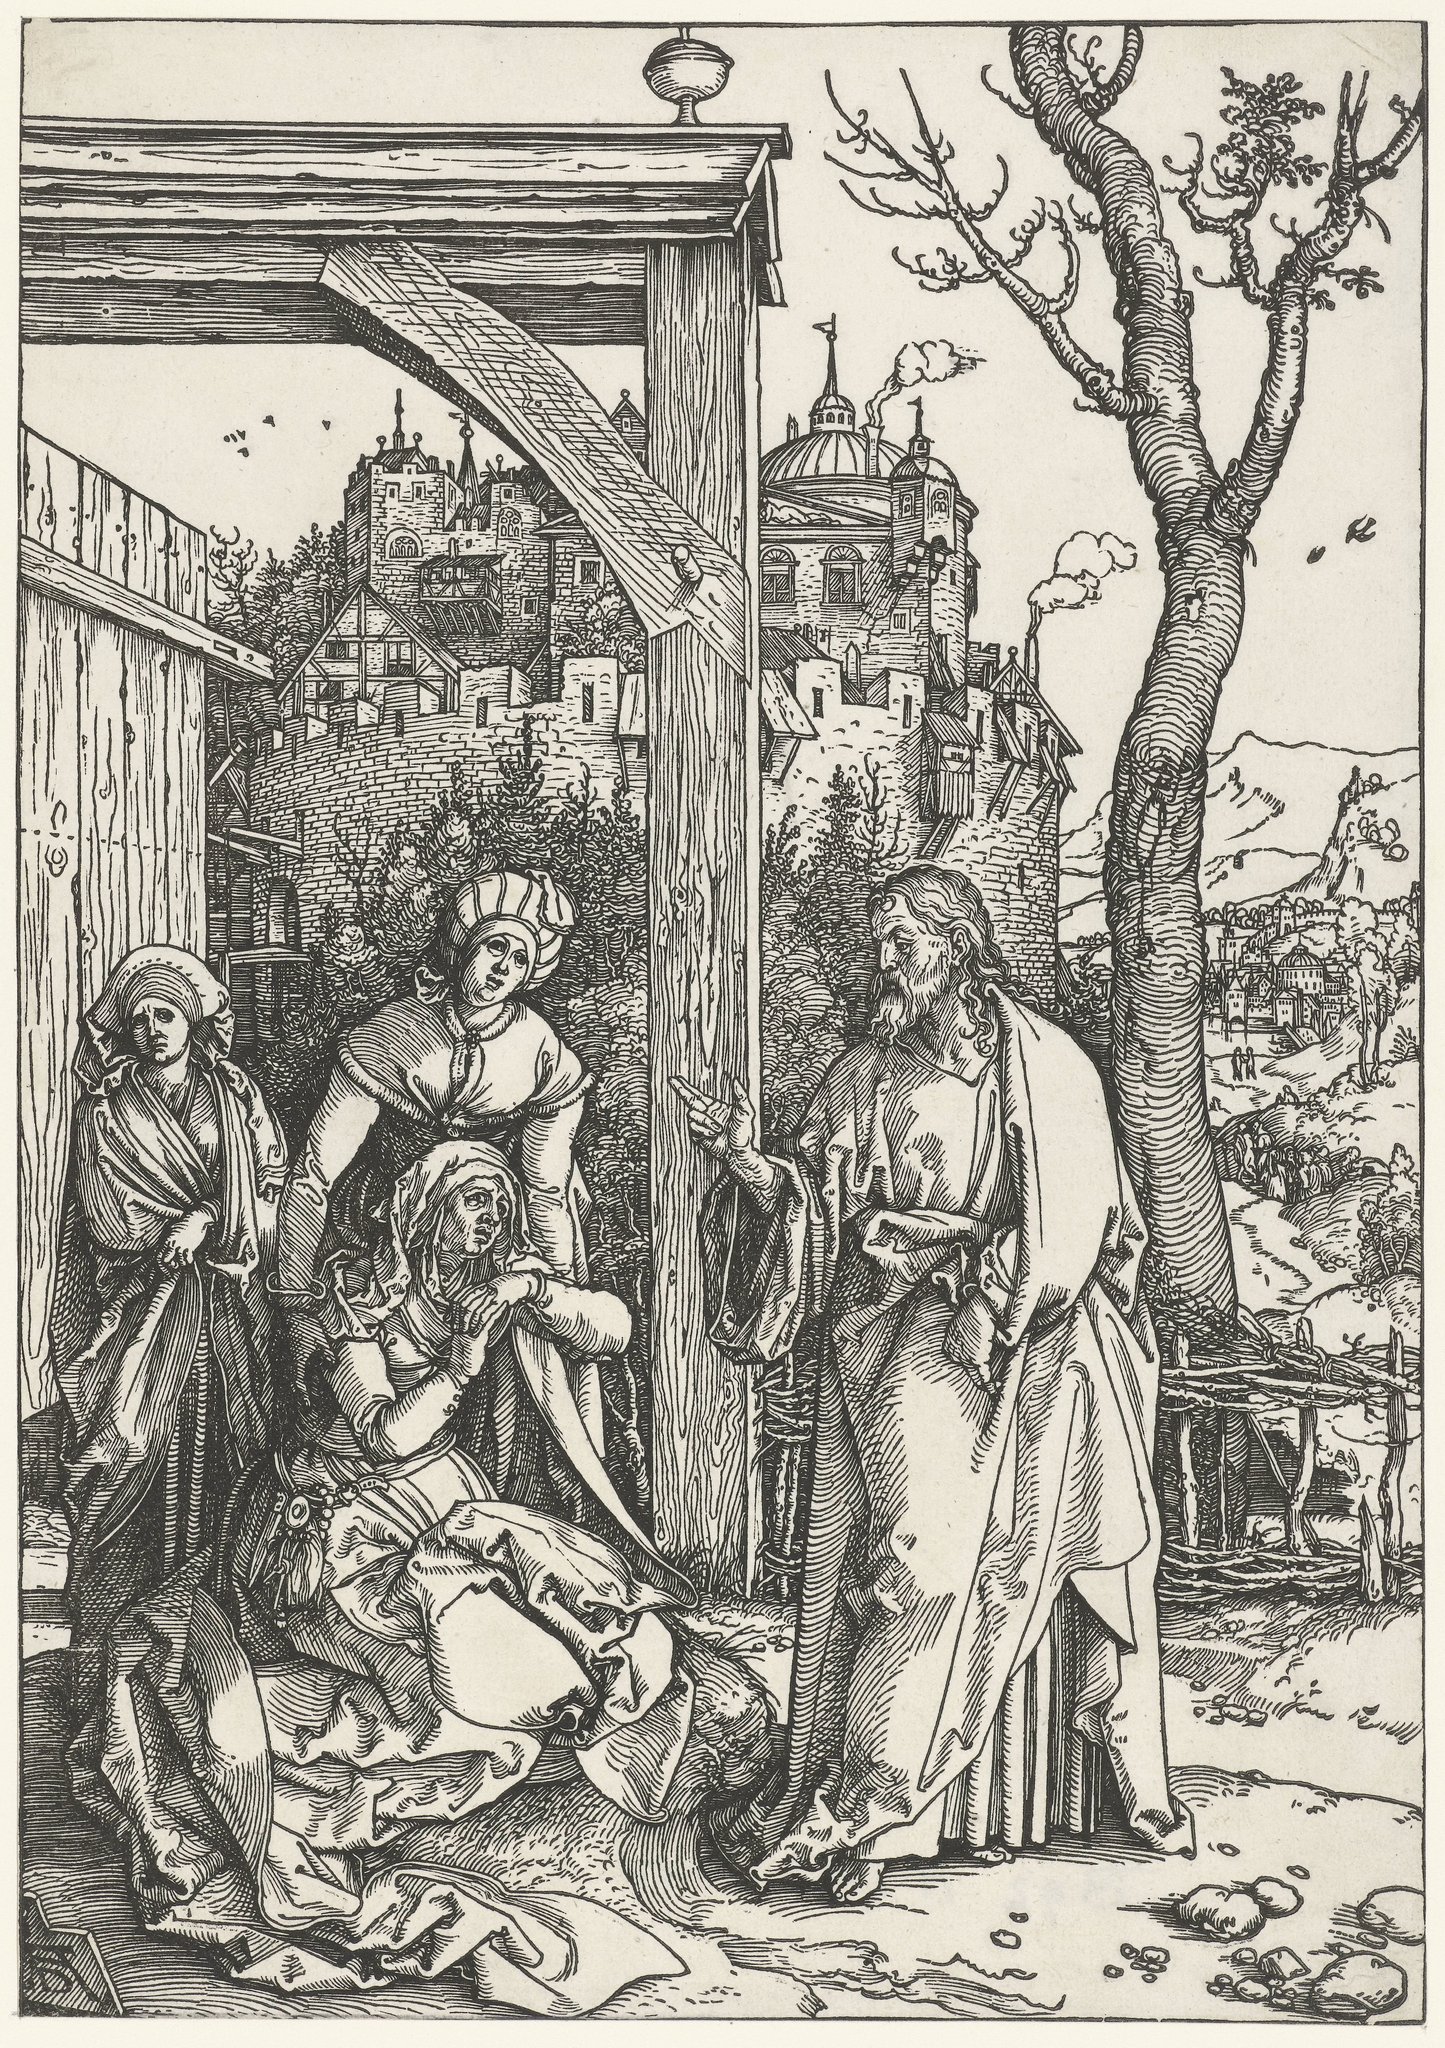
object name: print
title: Leven van Maria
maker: albrecht dürer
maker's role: draughtsman, painter, print maker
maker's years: 1471-1528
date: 1502-1506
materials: paper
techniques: woodcut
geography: nuremberg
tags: christ taking leave of mary, usually mary magdalene present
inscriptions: collector's mark: Lugt 2228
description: Maria knielt met van verdriet vertrokken gezicht voor Christus, die afscheid van haar neemt. Twee vrouwen (Martha en Maria Magdalena) staan achter Maria. Op de achtergrond een burcht of stad. Deze prent is onderdeel van een serie van 20 prenten, bestaand uit een titelprent en 19 prenten met scènes uit het leven van Maria.